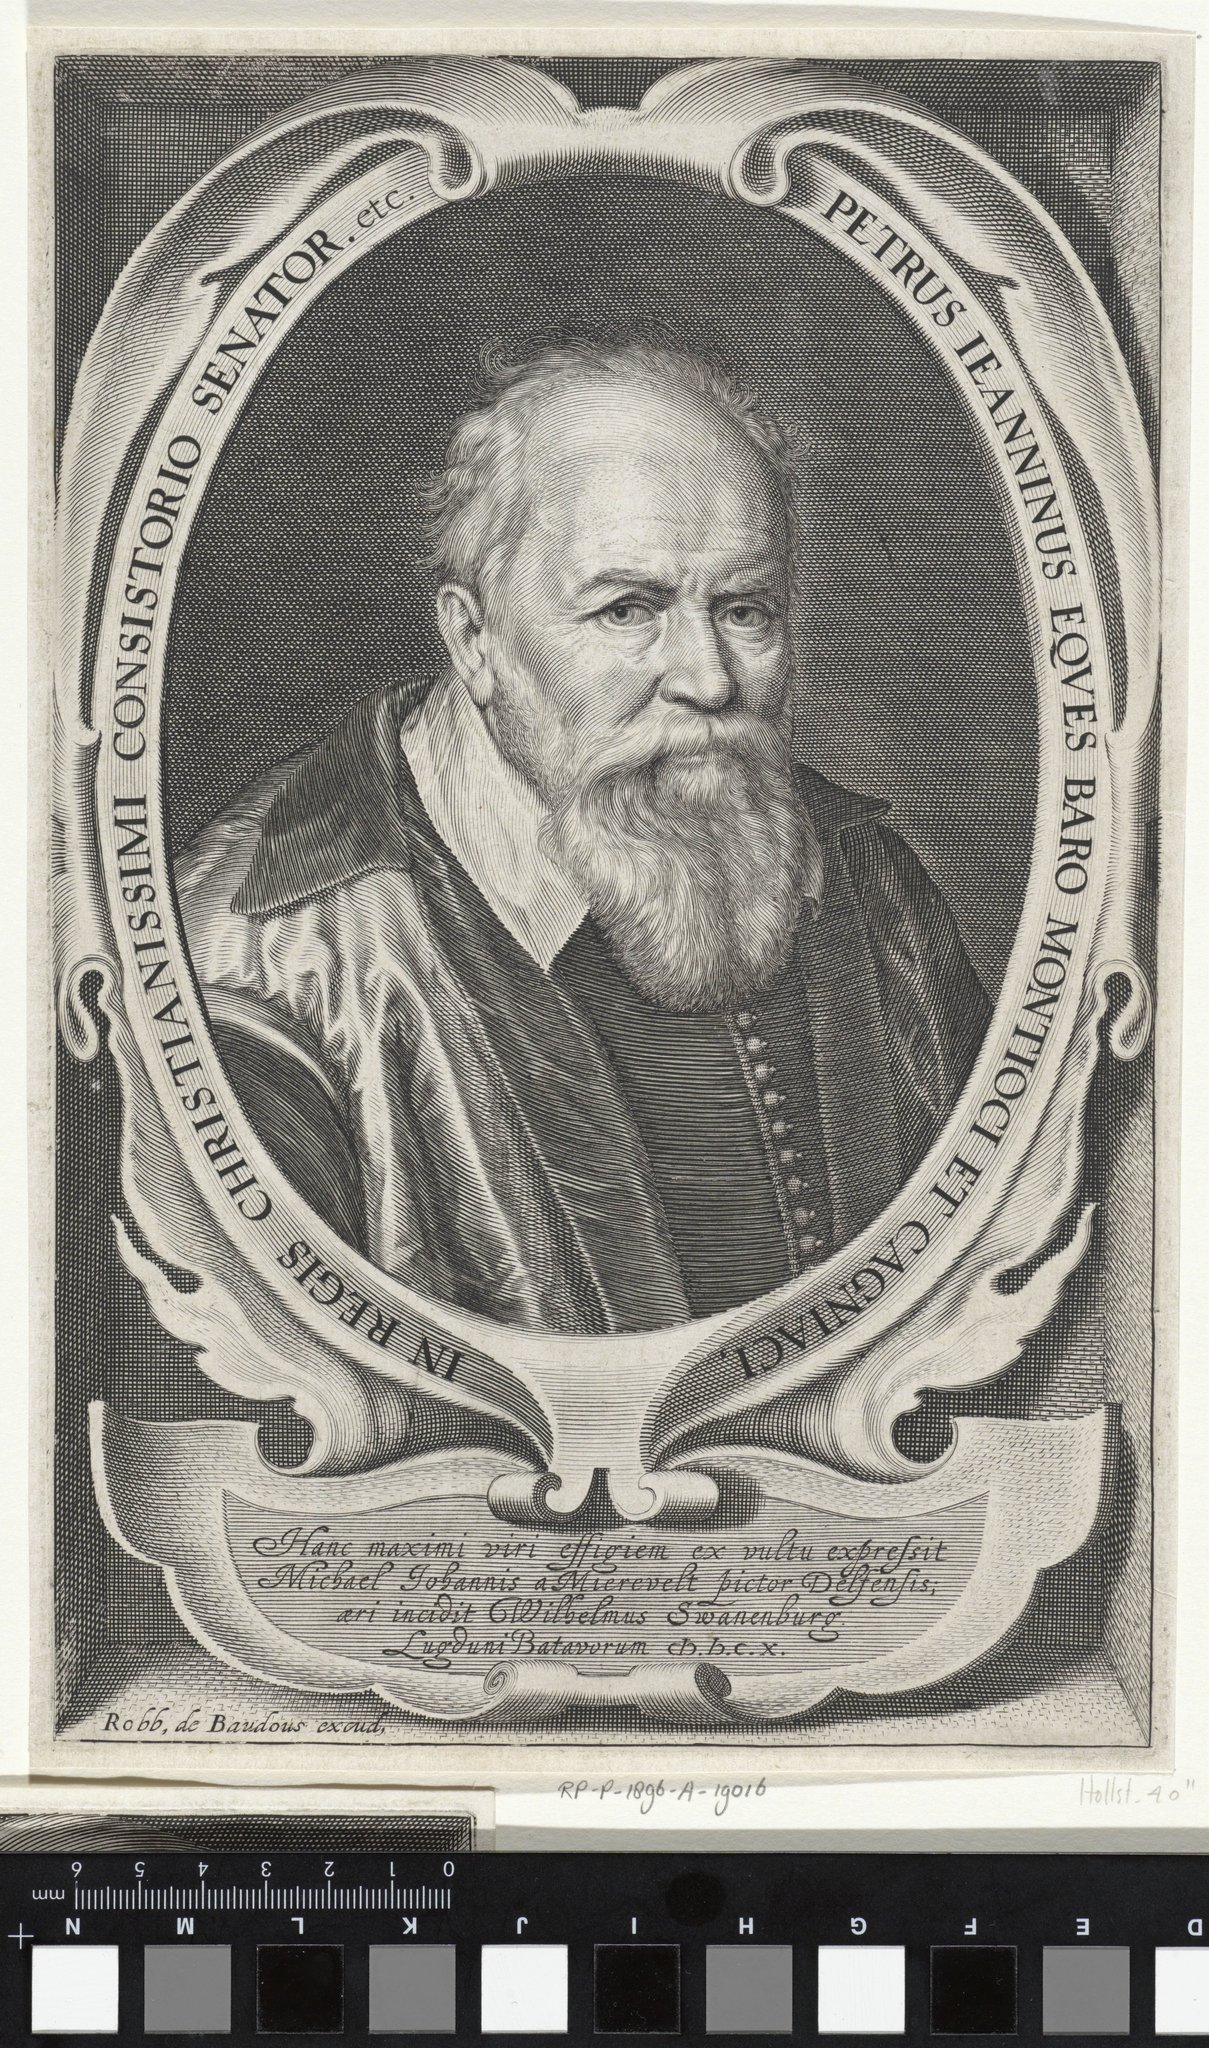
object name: print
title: Portret van Pierre Jeannin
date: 1610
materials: paper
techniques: engraving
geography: netherlands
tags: paris, ambassador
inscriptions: collector's mark: Lugt 2228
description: Portret van Pierre Jeannin, afgevaardigde namens Frankrijk bij de vredesonderhandelingen voor het Twaalfjarig Bestand en Frans ambassadeur te Den Haag, in een ornamentele lijst.